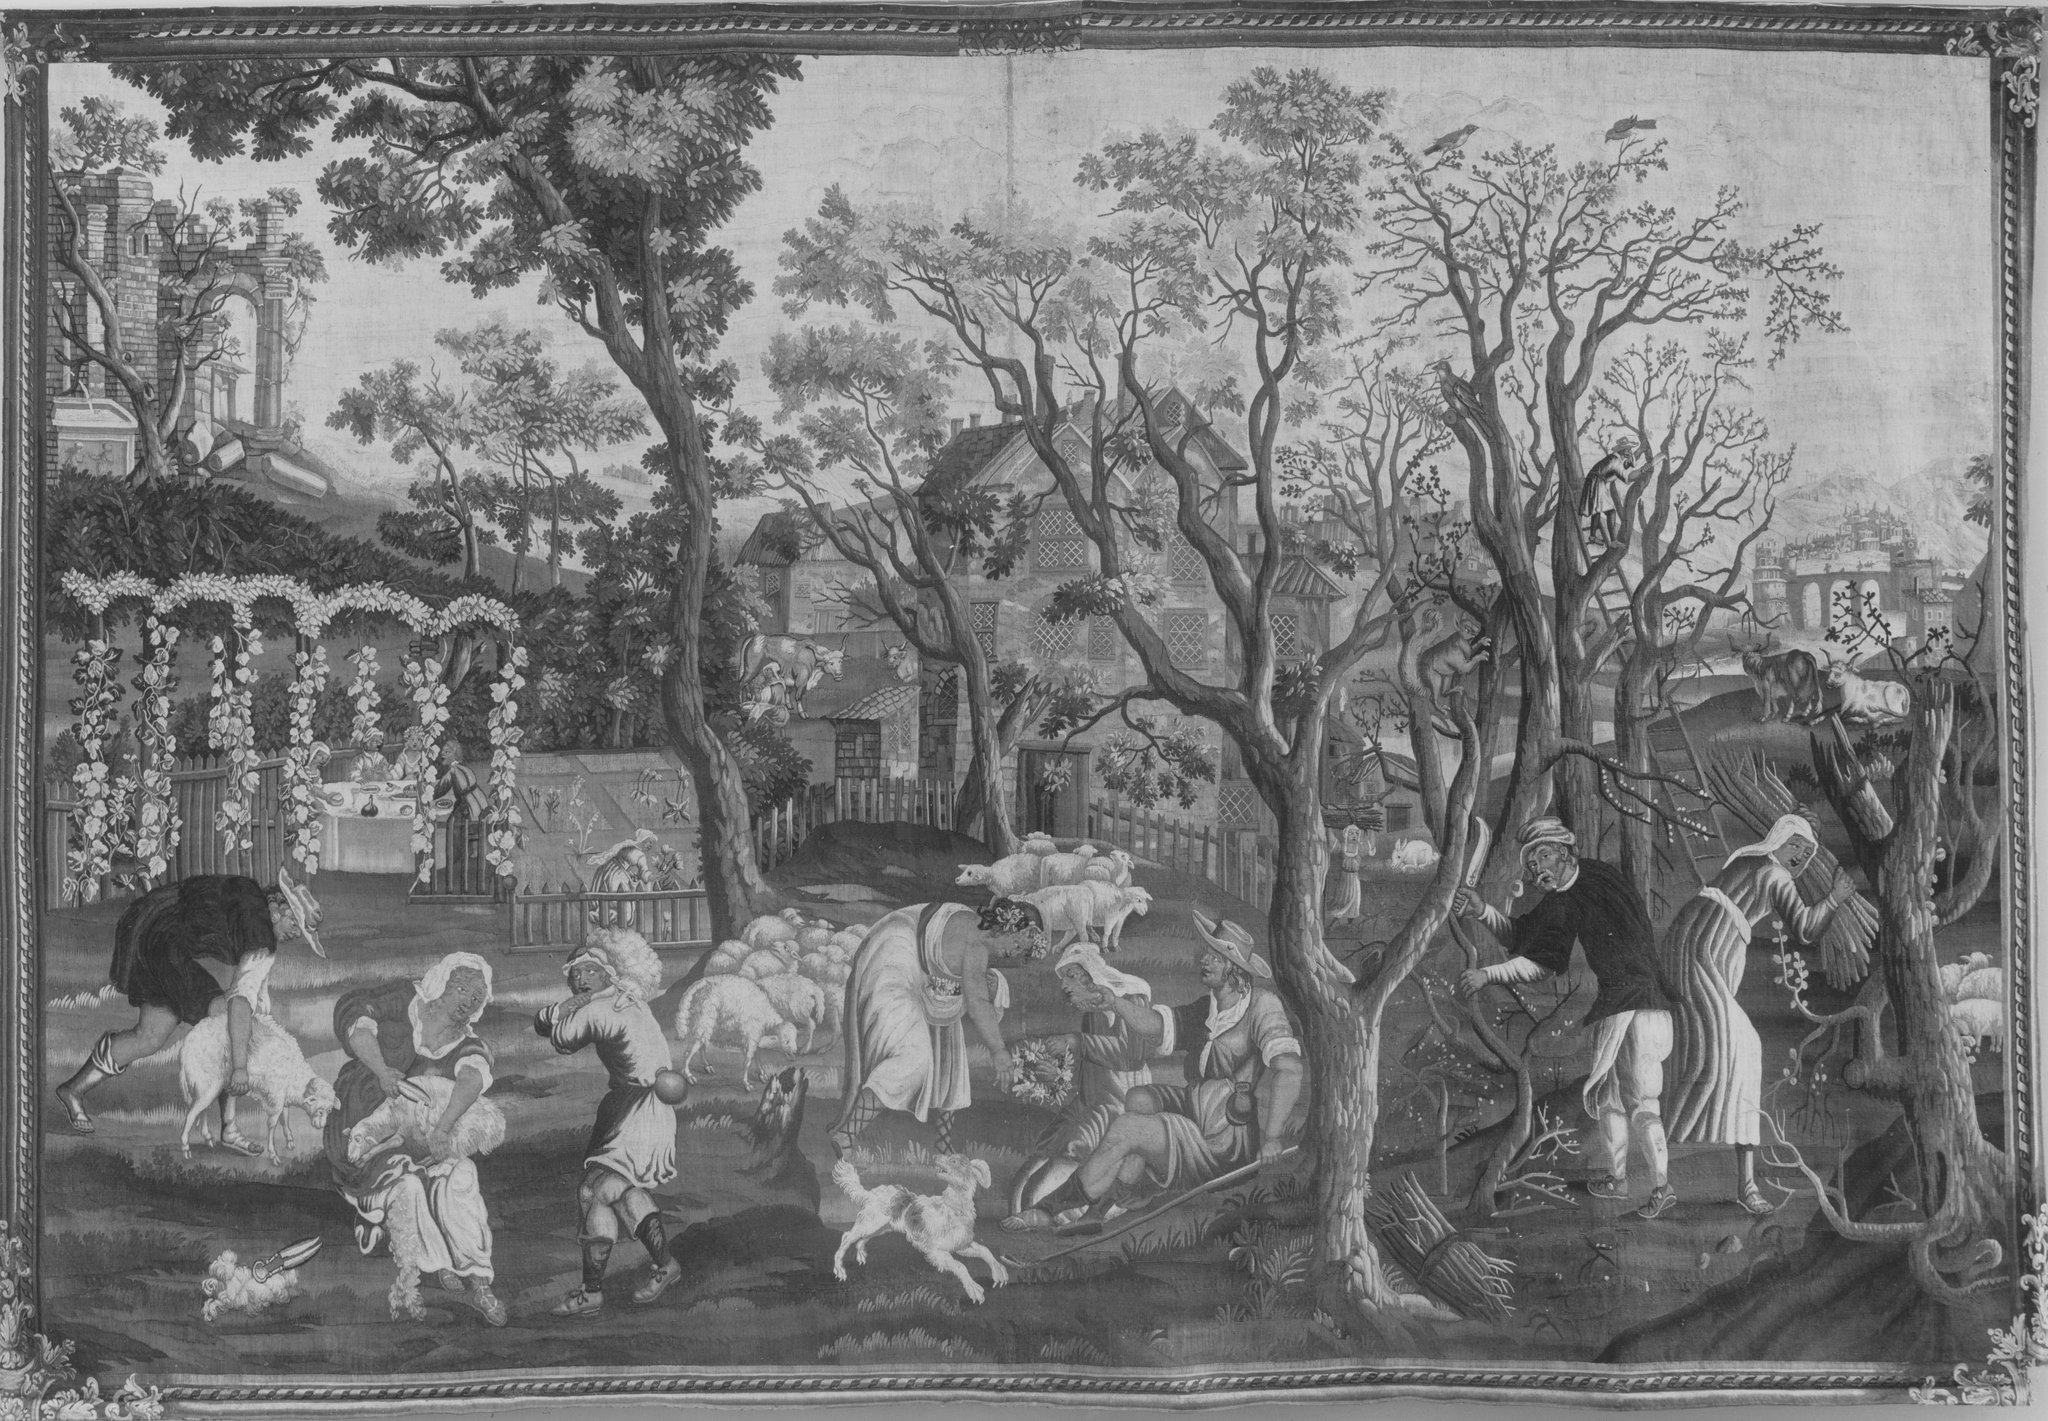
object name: tapestry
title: Spring from a set of The Seasons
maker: john chabanex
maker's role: maker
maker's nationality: french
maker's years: 1696-1744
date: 1701-1733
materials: silk, wool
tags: men,women,dogs,sheep,spring,working